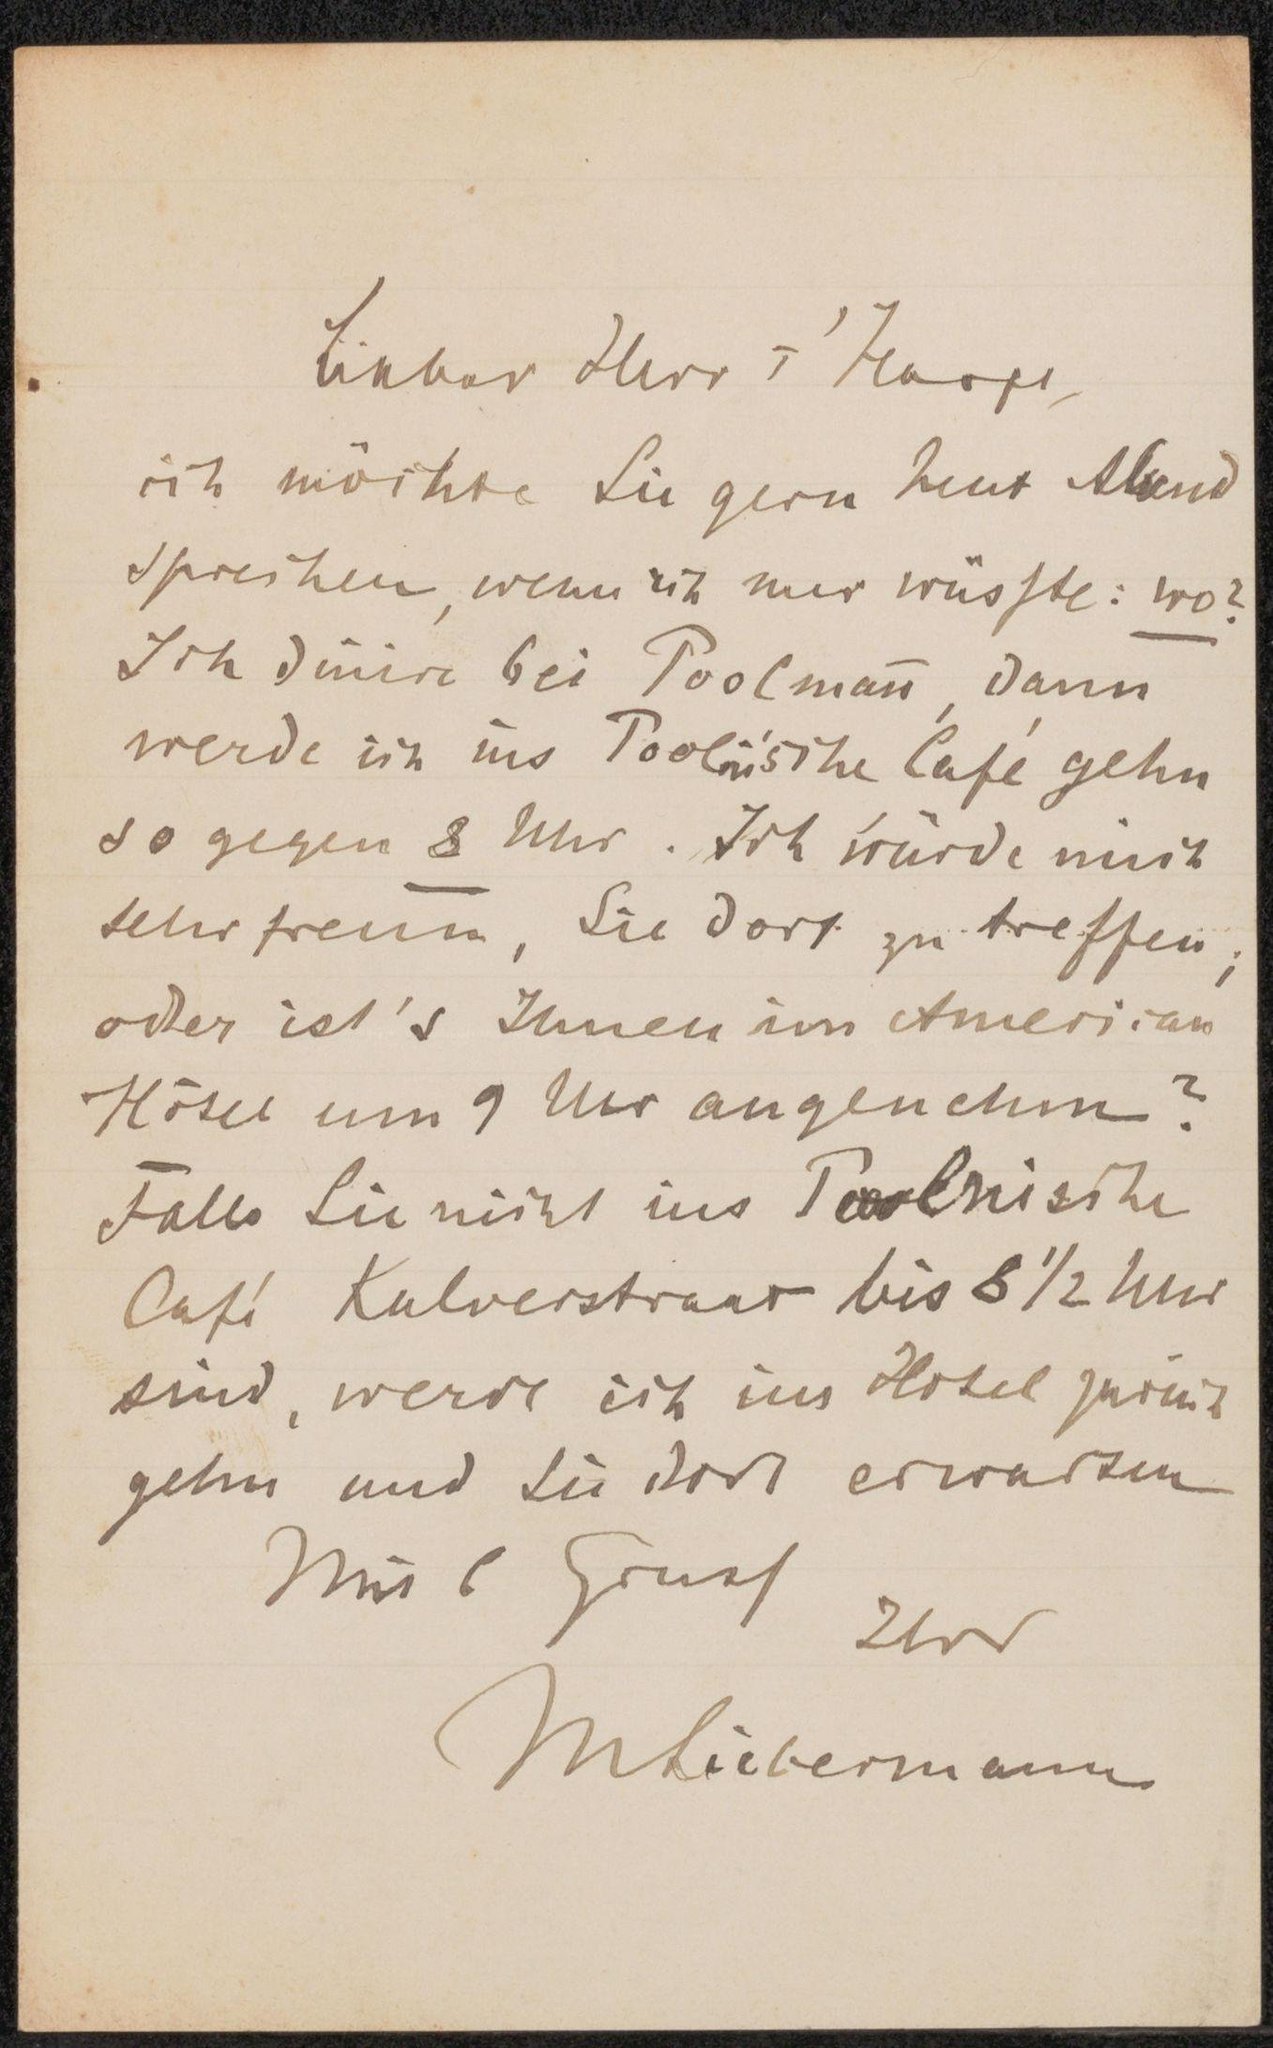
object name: letter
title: Brief aan Cornelis Gerardus 't Hooft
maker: max liebermann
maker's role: draughtsman, print maker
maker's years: 1847-1935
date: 1876-1935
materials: ink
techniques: pen, writing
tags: painter, cornelis gerardus 't hooft, amsterdam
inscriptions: collector's mark: Lugt 2228a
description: Bij de brief wordt een aantekening betreffende het object bewaard.